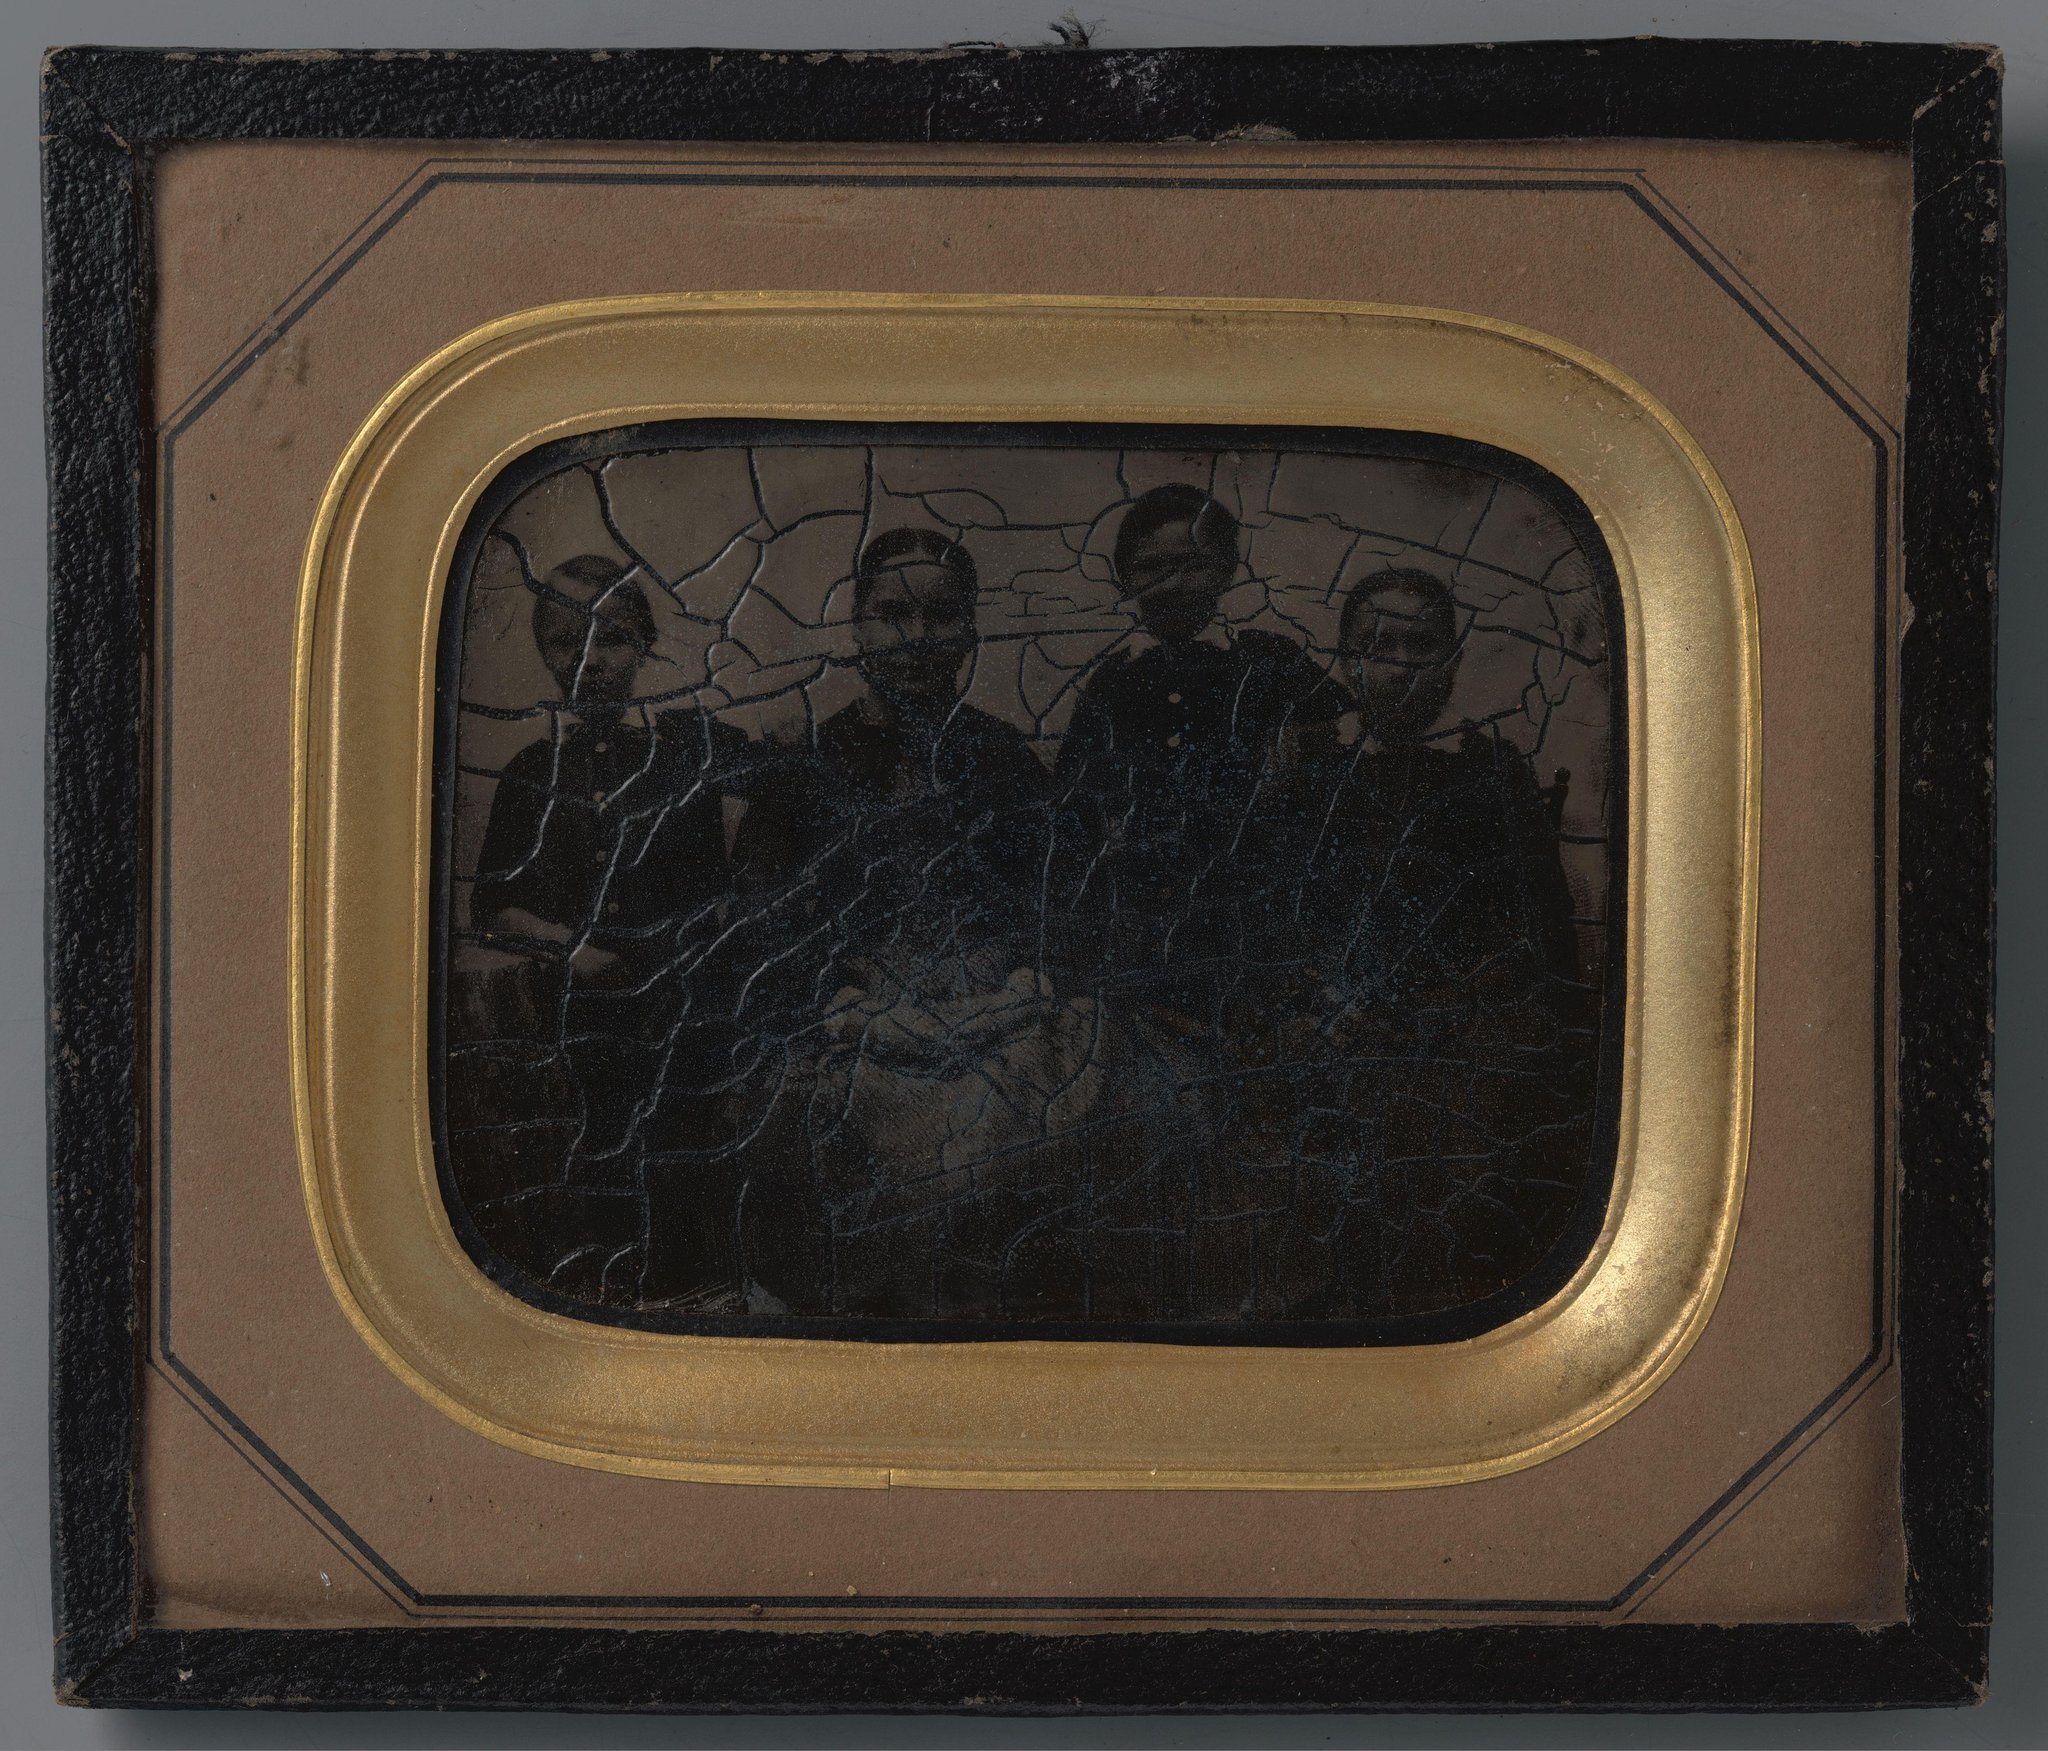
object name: photograph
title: Portret van Richard Hofmann, Agnes Günzel geboren Hofmann, Berta Hofmann en Hermann Hofmann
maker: Anonymous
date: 1853-1863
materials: glass, linen, metal, paper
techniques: pannotype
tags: boy (child between toddler and youth) (+ two persons), adolescent, young woman, maiden (+ two persons), anonymous historical persons portrayed in a group, in a group-portrait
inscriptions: annotation: ‘Sc[...]/ 12’, annotation: ‘2. Agnes Günzel, geb. Hofmann,/ 4. Berta Hofmann,/ 3. Hermann Hofmann,/ 1. Richard Hofmann.’